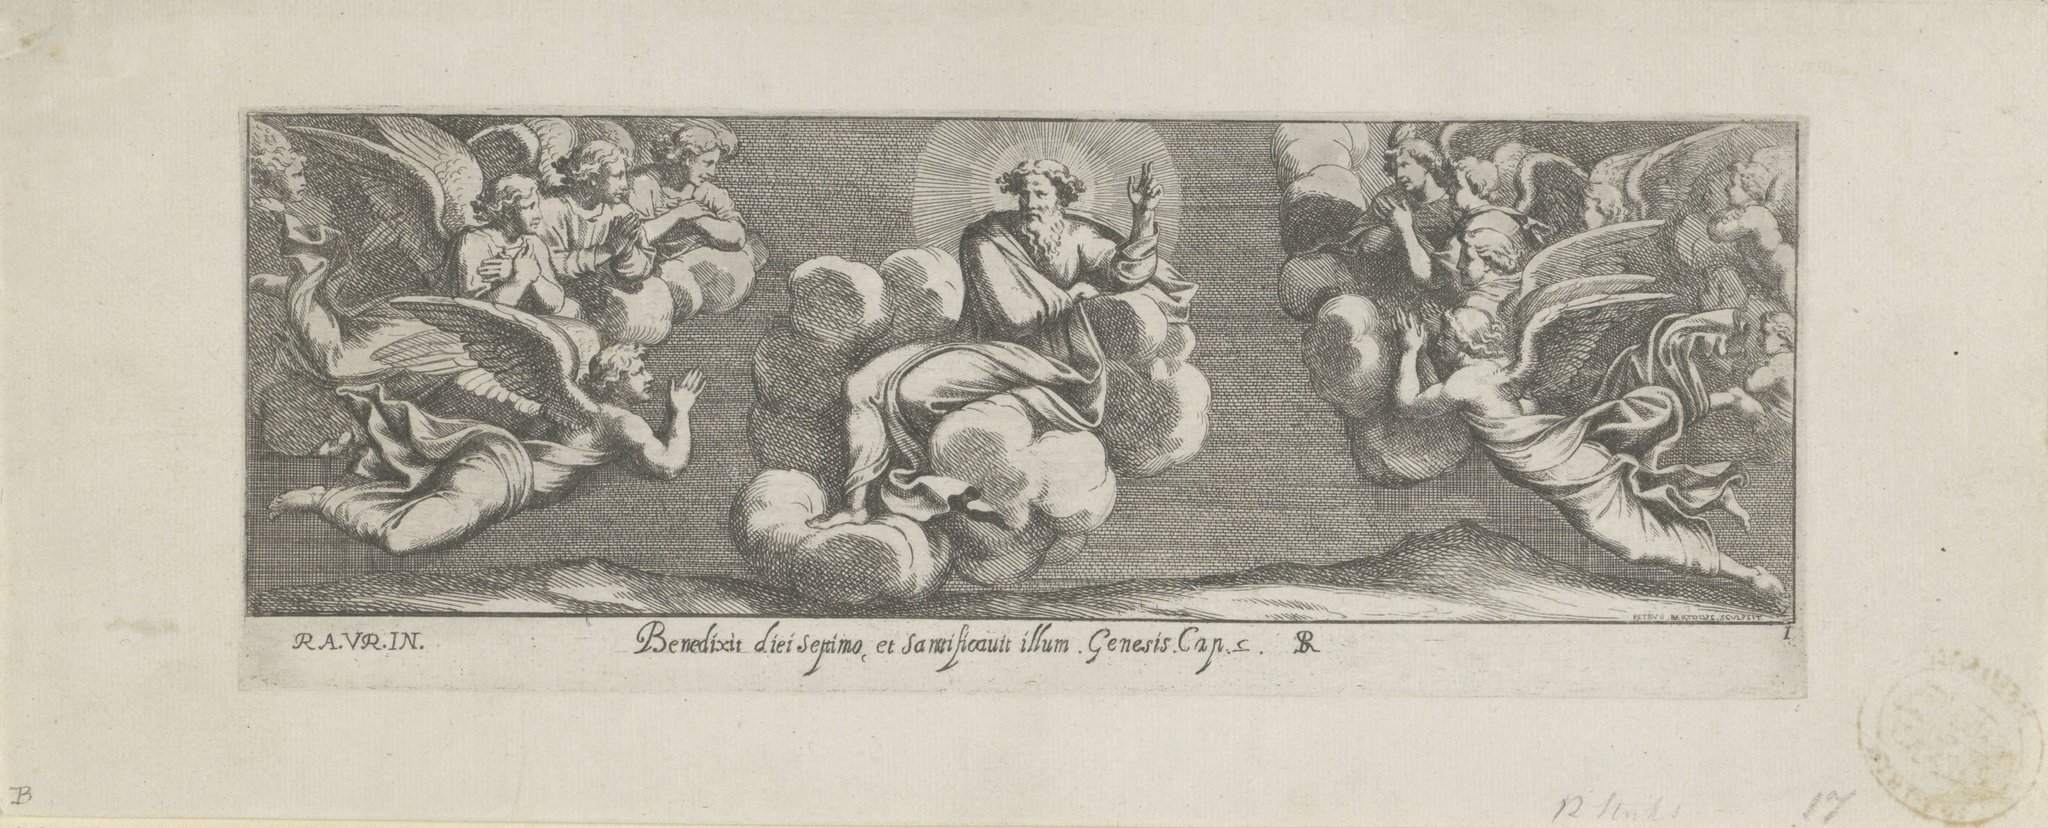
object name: print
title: Benedixit diei septimo, et sanctificavit illum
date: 1645-1700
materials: paper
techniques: engraving, etching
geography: italy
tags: god rests on the seventh day, angels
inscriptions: collector's mark: Lugt 240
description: God zwevend op een wolk. Met zijn hand maakt hij een zegenend gebaar. Links en rechts zwevende engelen. Titel en verwijzing naar Bijbeltekst in ondermarge. Genummerd rechtsonder: 1.